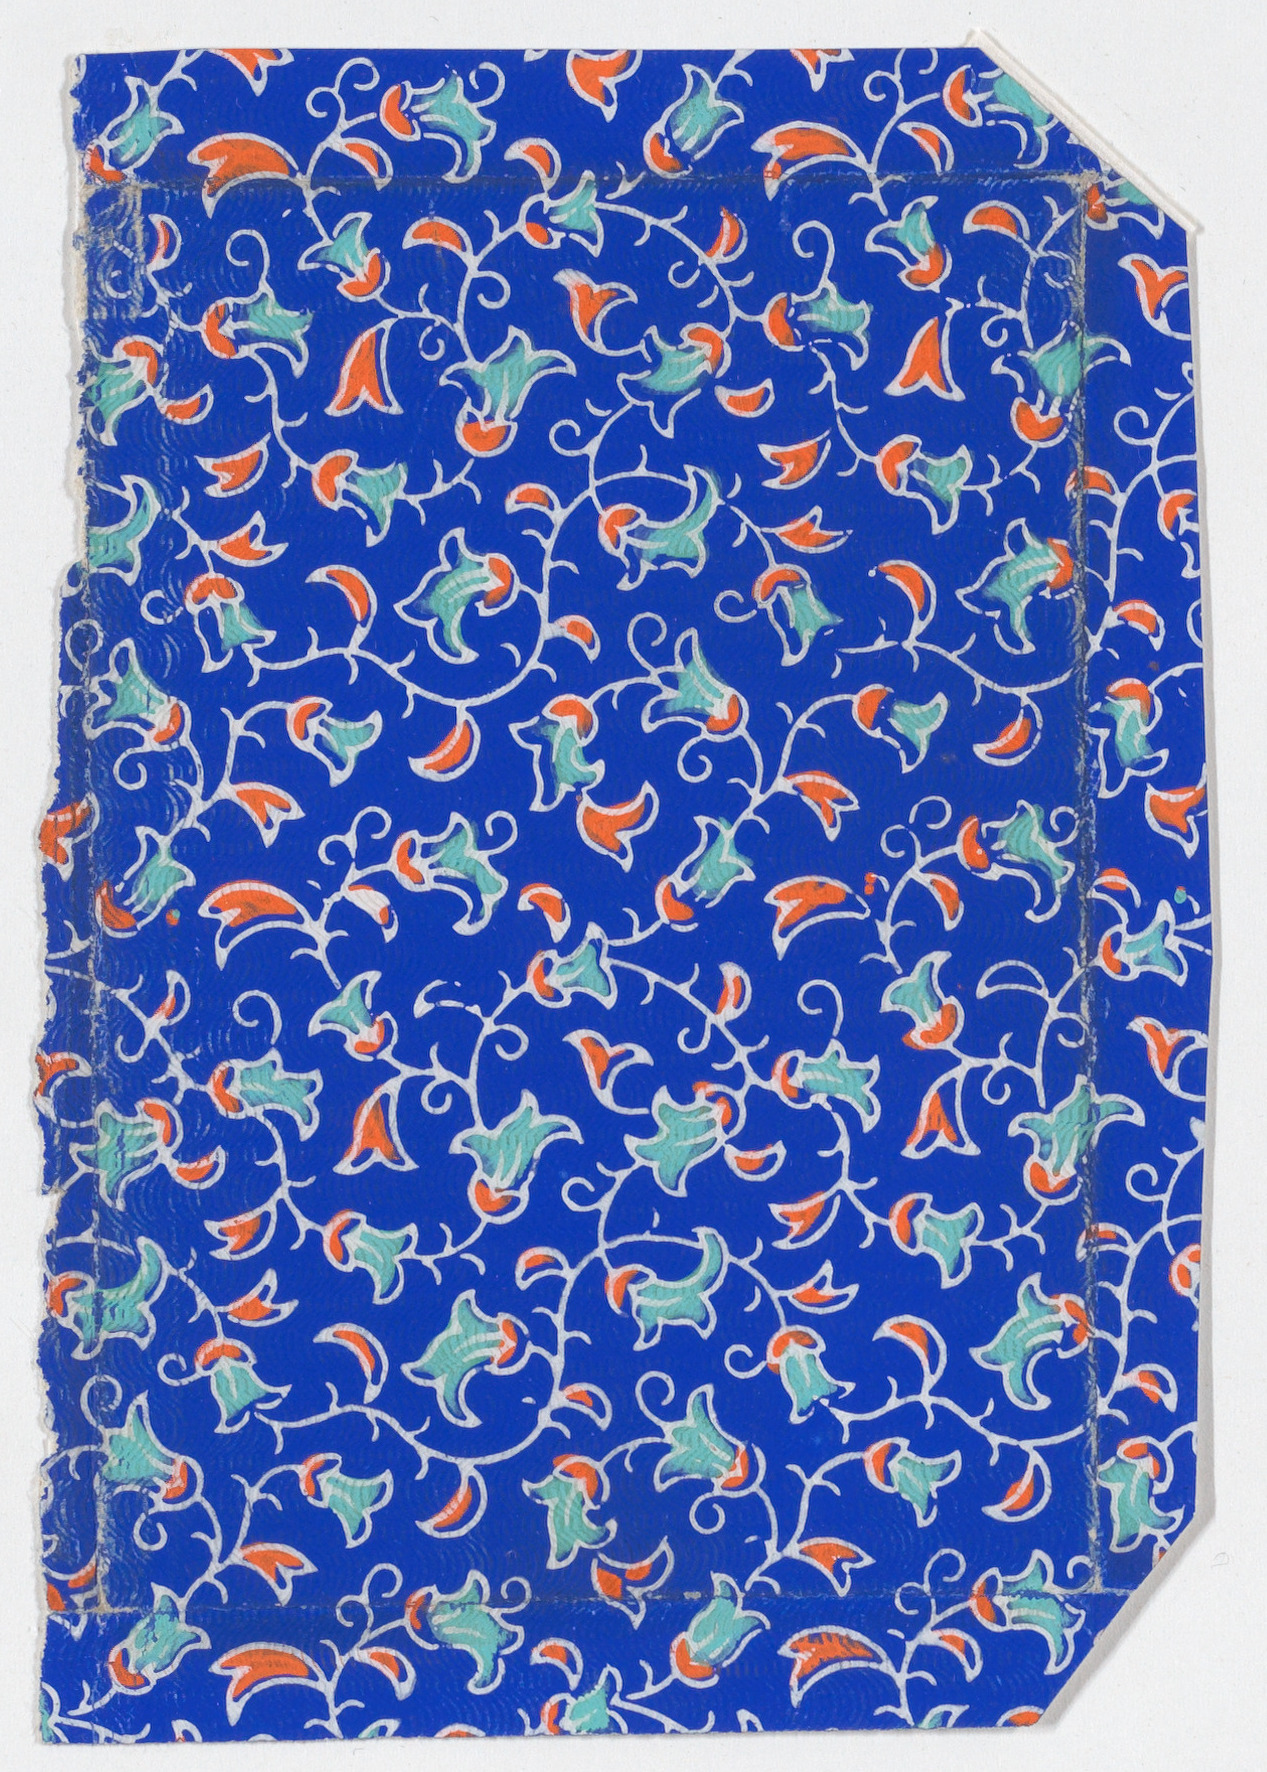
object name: print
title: Bright blue sheet with vine pattern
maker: Anonymous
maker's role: artist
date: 1801-1900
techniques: relief print